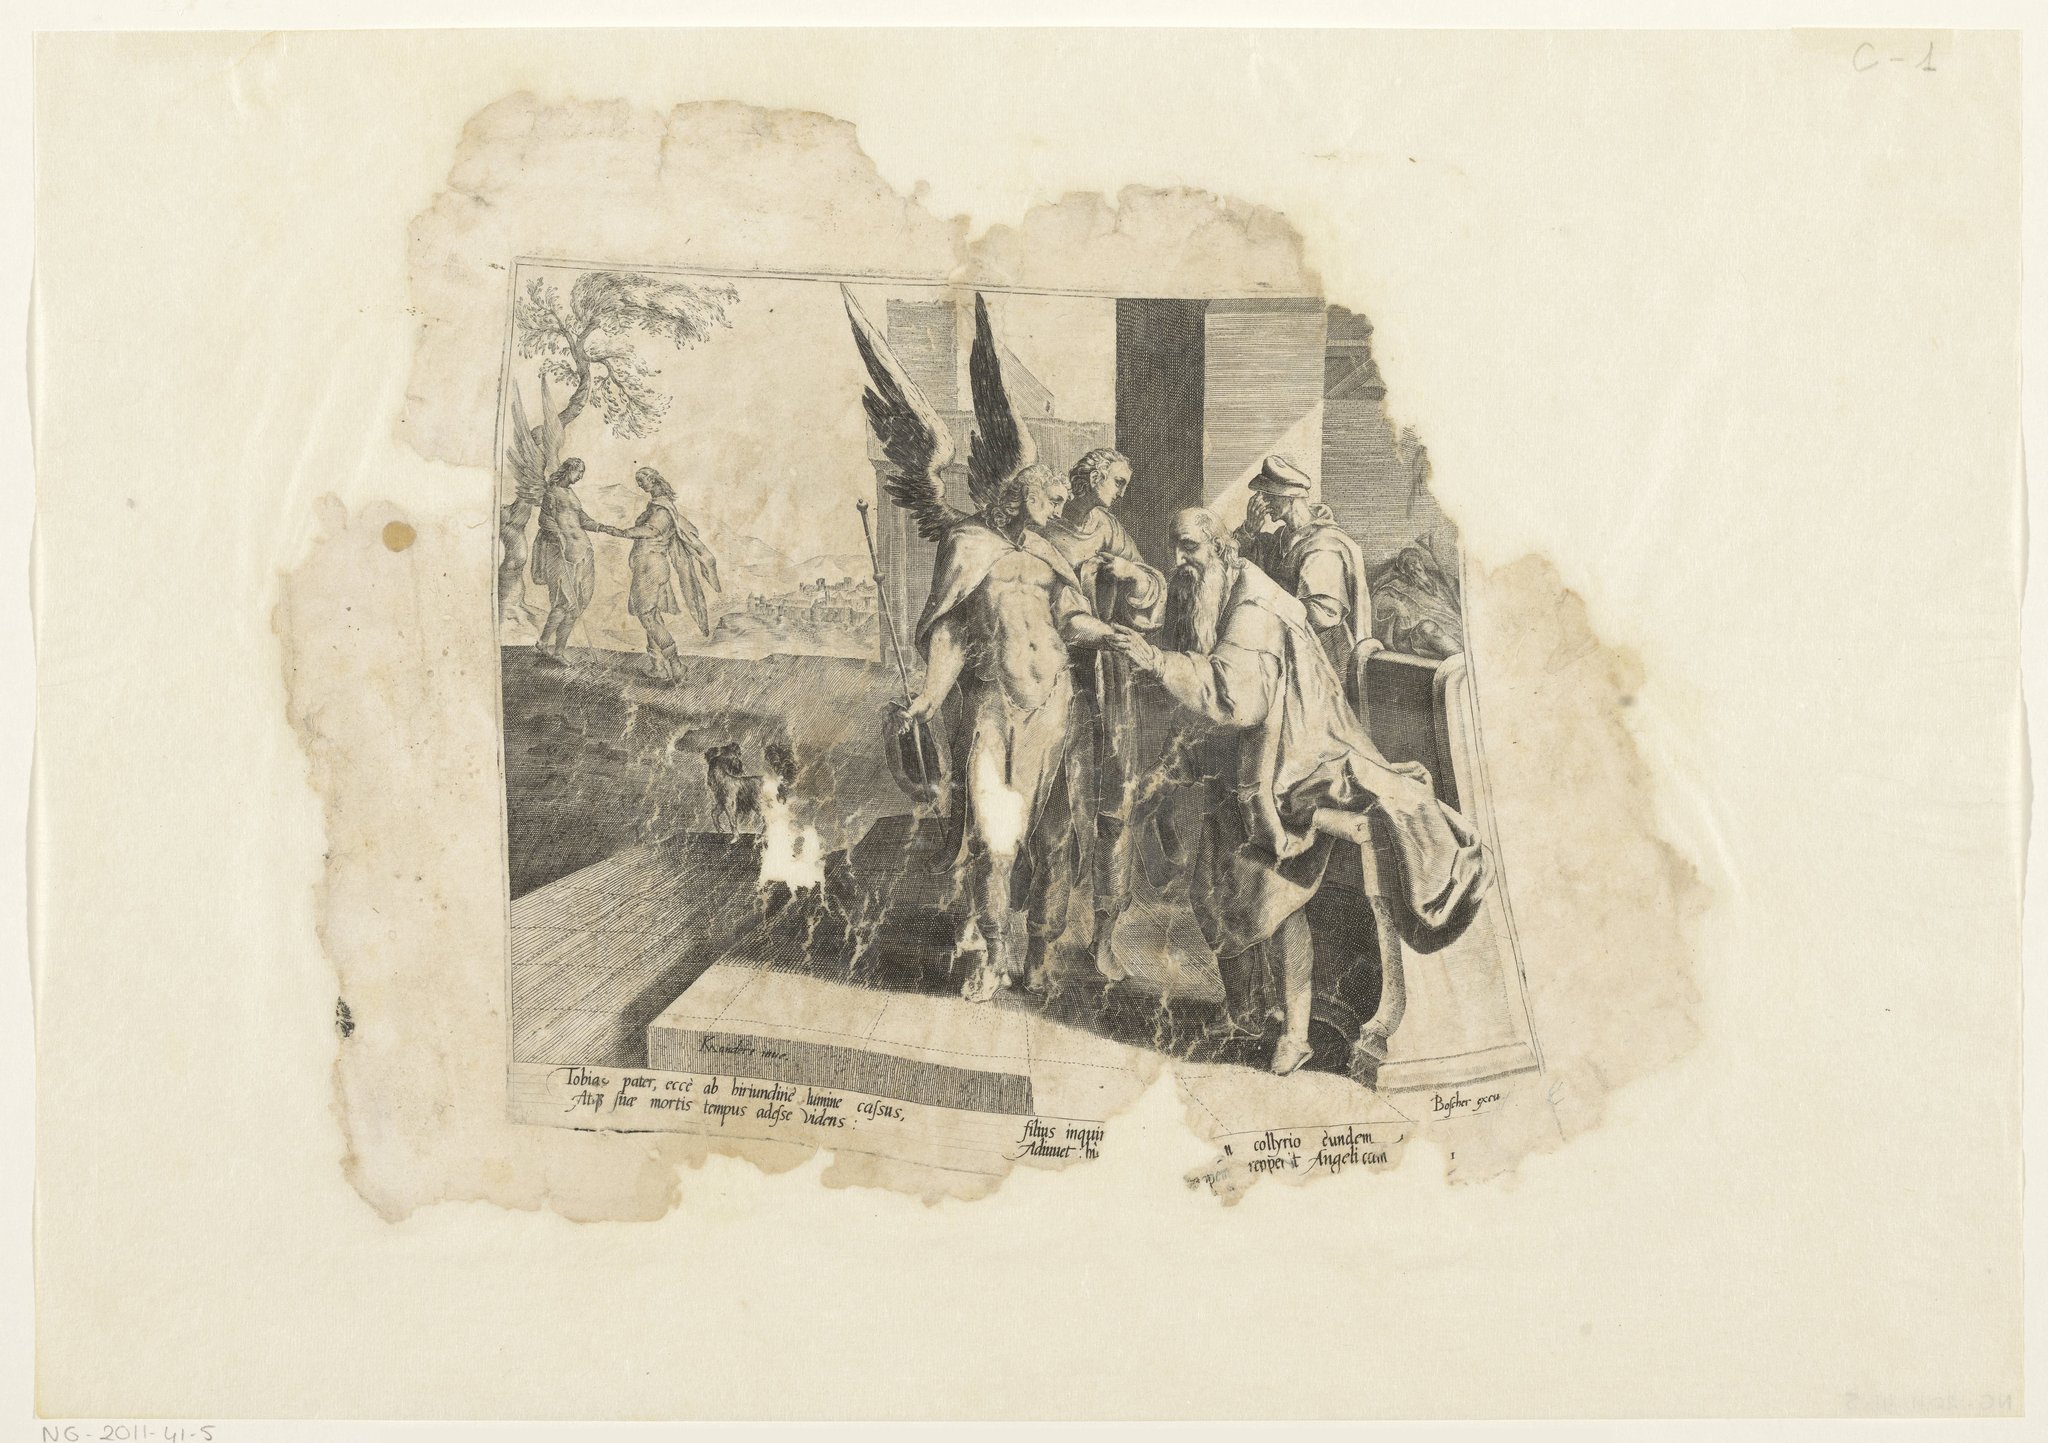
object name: print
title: Afscheid van Tobias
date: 1580-1596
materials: paper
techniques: engraving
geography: amsterdam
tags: tobias taking leave of his parents; anna mourns her son's departure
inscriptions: watermark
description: De prenten in de Nova Zembla collectie zijn tijdens een expeditie van Willem Barendsz en Jacob van Heemskerk in 1596-1597 noodgedwongen in het winterkamp, het ‘Behouden Huis’, op het eiland achtergelaten. De prenten waren in één of meerdere stapels als handelswaar meegenomen vanuit Amsterdam. Bijna drie eeuwen later, in 1871, keerde de Noor Elling Carlsen terug naar Nova Zembla en vond daar de restanten van het ‘Behouden Huis, inclusief een groot deel van de inventaris. Een deel van de prenten, in de vorm van aaneengekoekte kluiten, werd toen ook teruggevonden. De papierkluiten waren soms op meerdere plekken gebroken. Tussen 1975-1979 zijn de prenten van elkaar gescheiden. Dit leverde in totaal ca. 1000 fragmenten van ca. 400 afdrukken van ca. 150 verschillende prenten op. Voor zover mogelijk zijn de fragmenten samengevoegd en zijn de prenten gereconstrueerd.